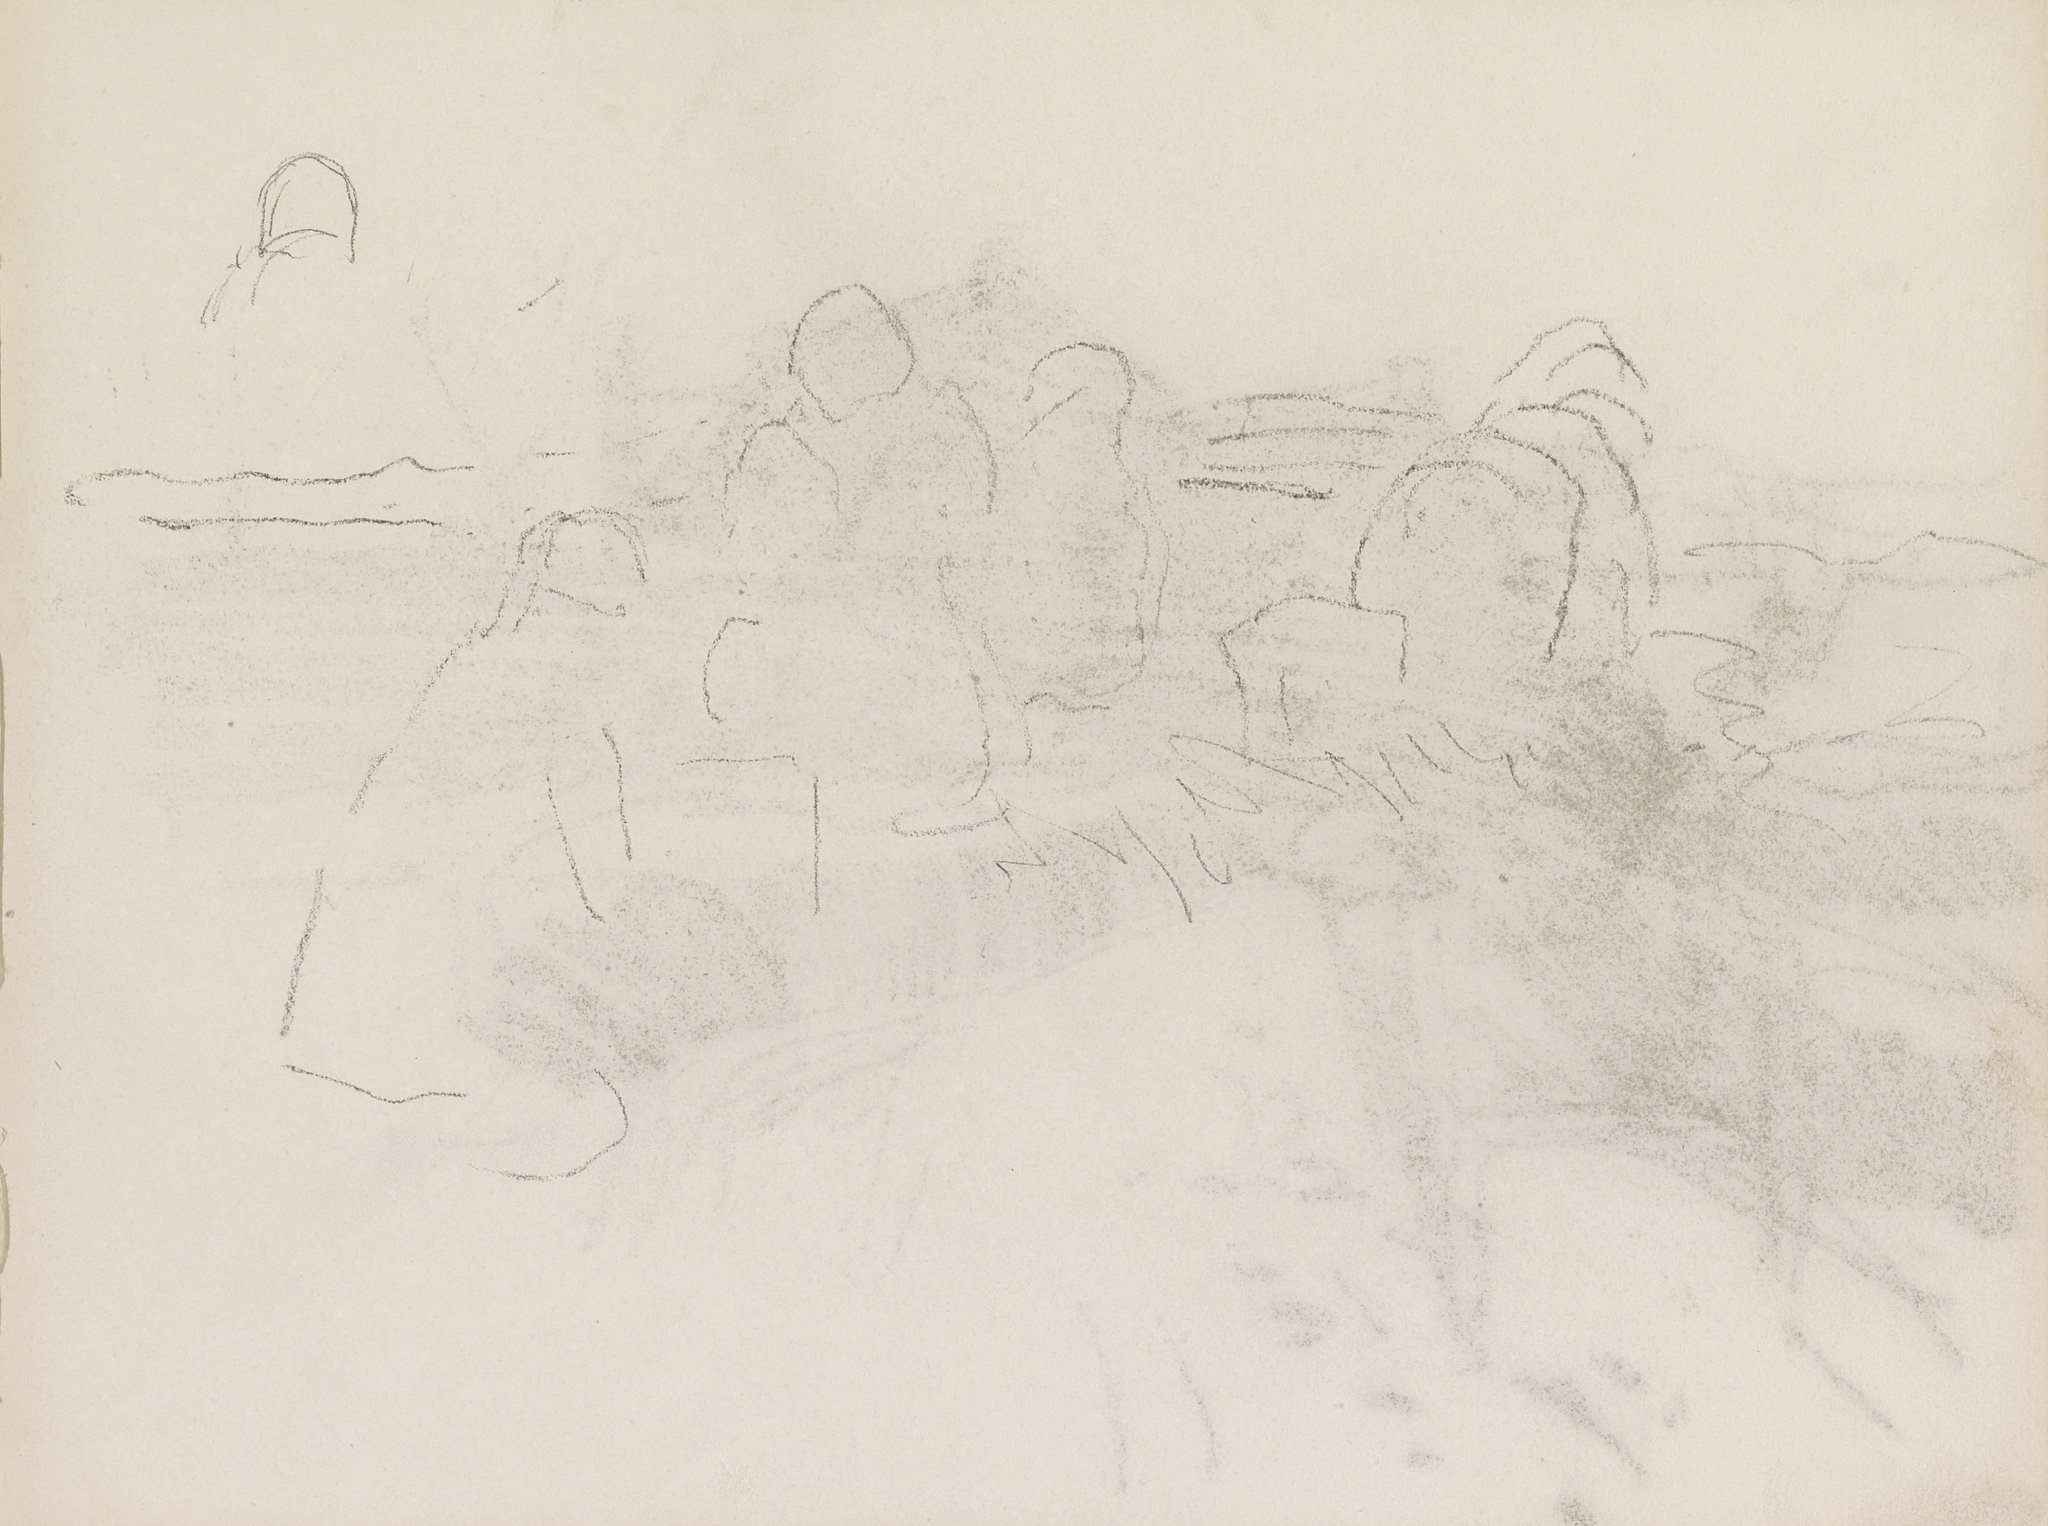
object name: sketchbook leaf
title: Aardappelrooiers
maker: anton mauve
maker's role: draughtsman, painter, print maker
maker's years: 1838-1888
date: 1886-1888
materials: chalk, paper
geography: laren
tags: plants cultivated for their edible roots or tubers, e.g. potato, turnip (labourers ~ crafts, industries, agriculture)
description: Blad 7 recto uit een schetsboek met 27 bladen.